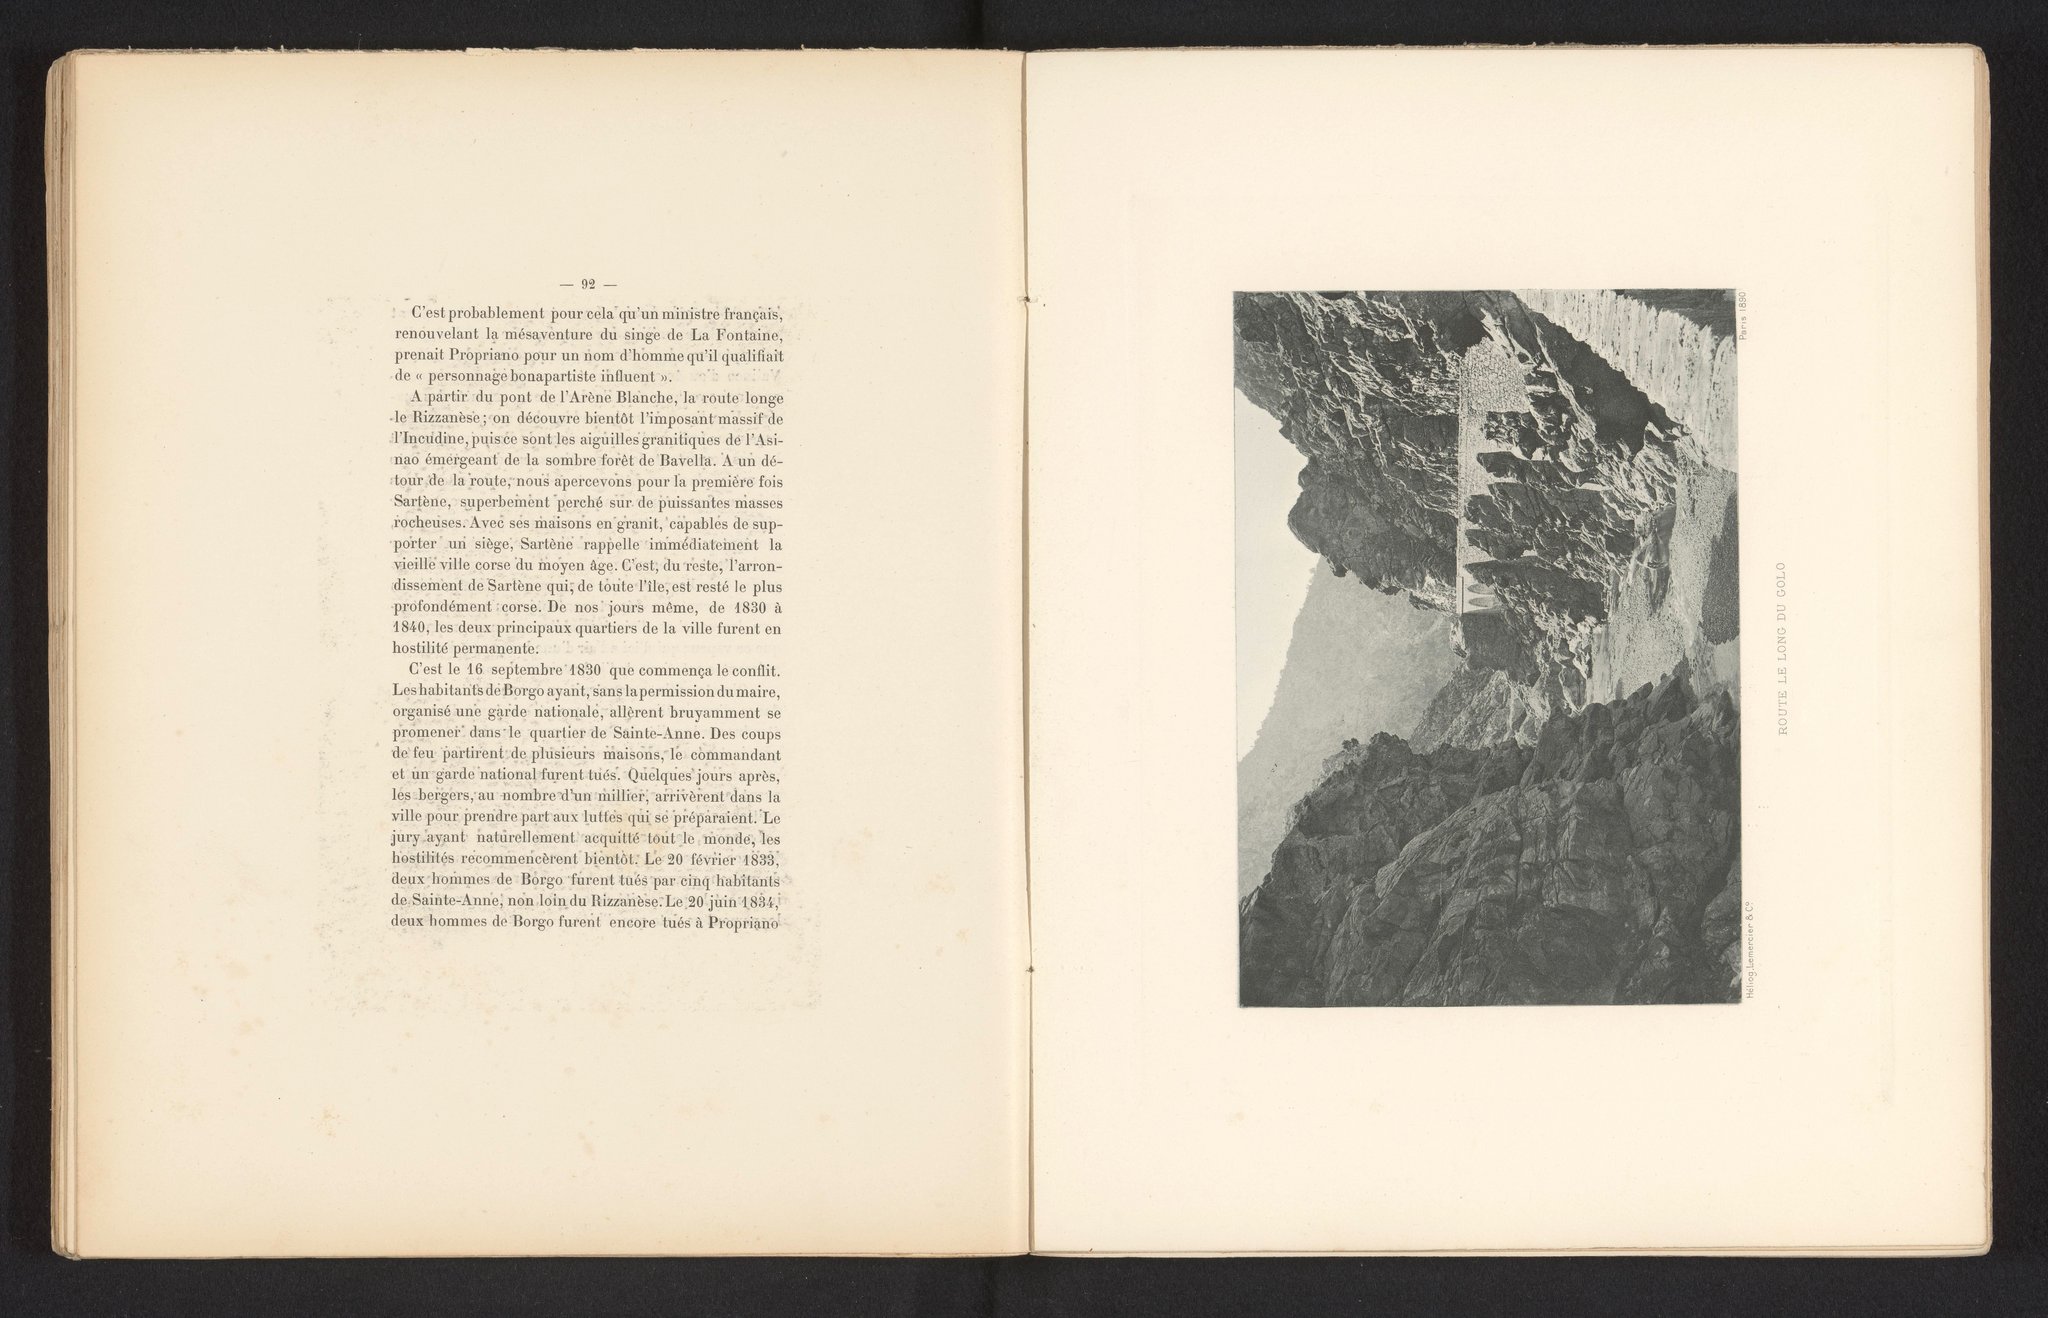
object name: page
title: Gezicht op een weg langs de rivier Golo te Corsica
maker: roland napoleon bonaparte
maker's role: botanicus, fotograaf, geograaf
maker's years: 1858-1924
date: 1881-1890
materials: paper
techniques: photoaquatint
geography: paris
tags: river, ravine, chasm, abyss, canyon, public road